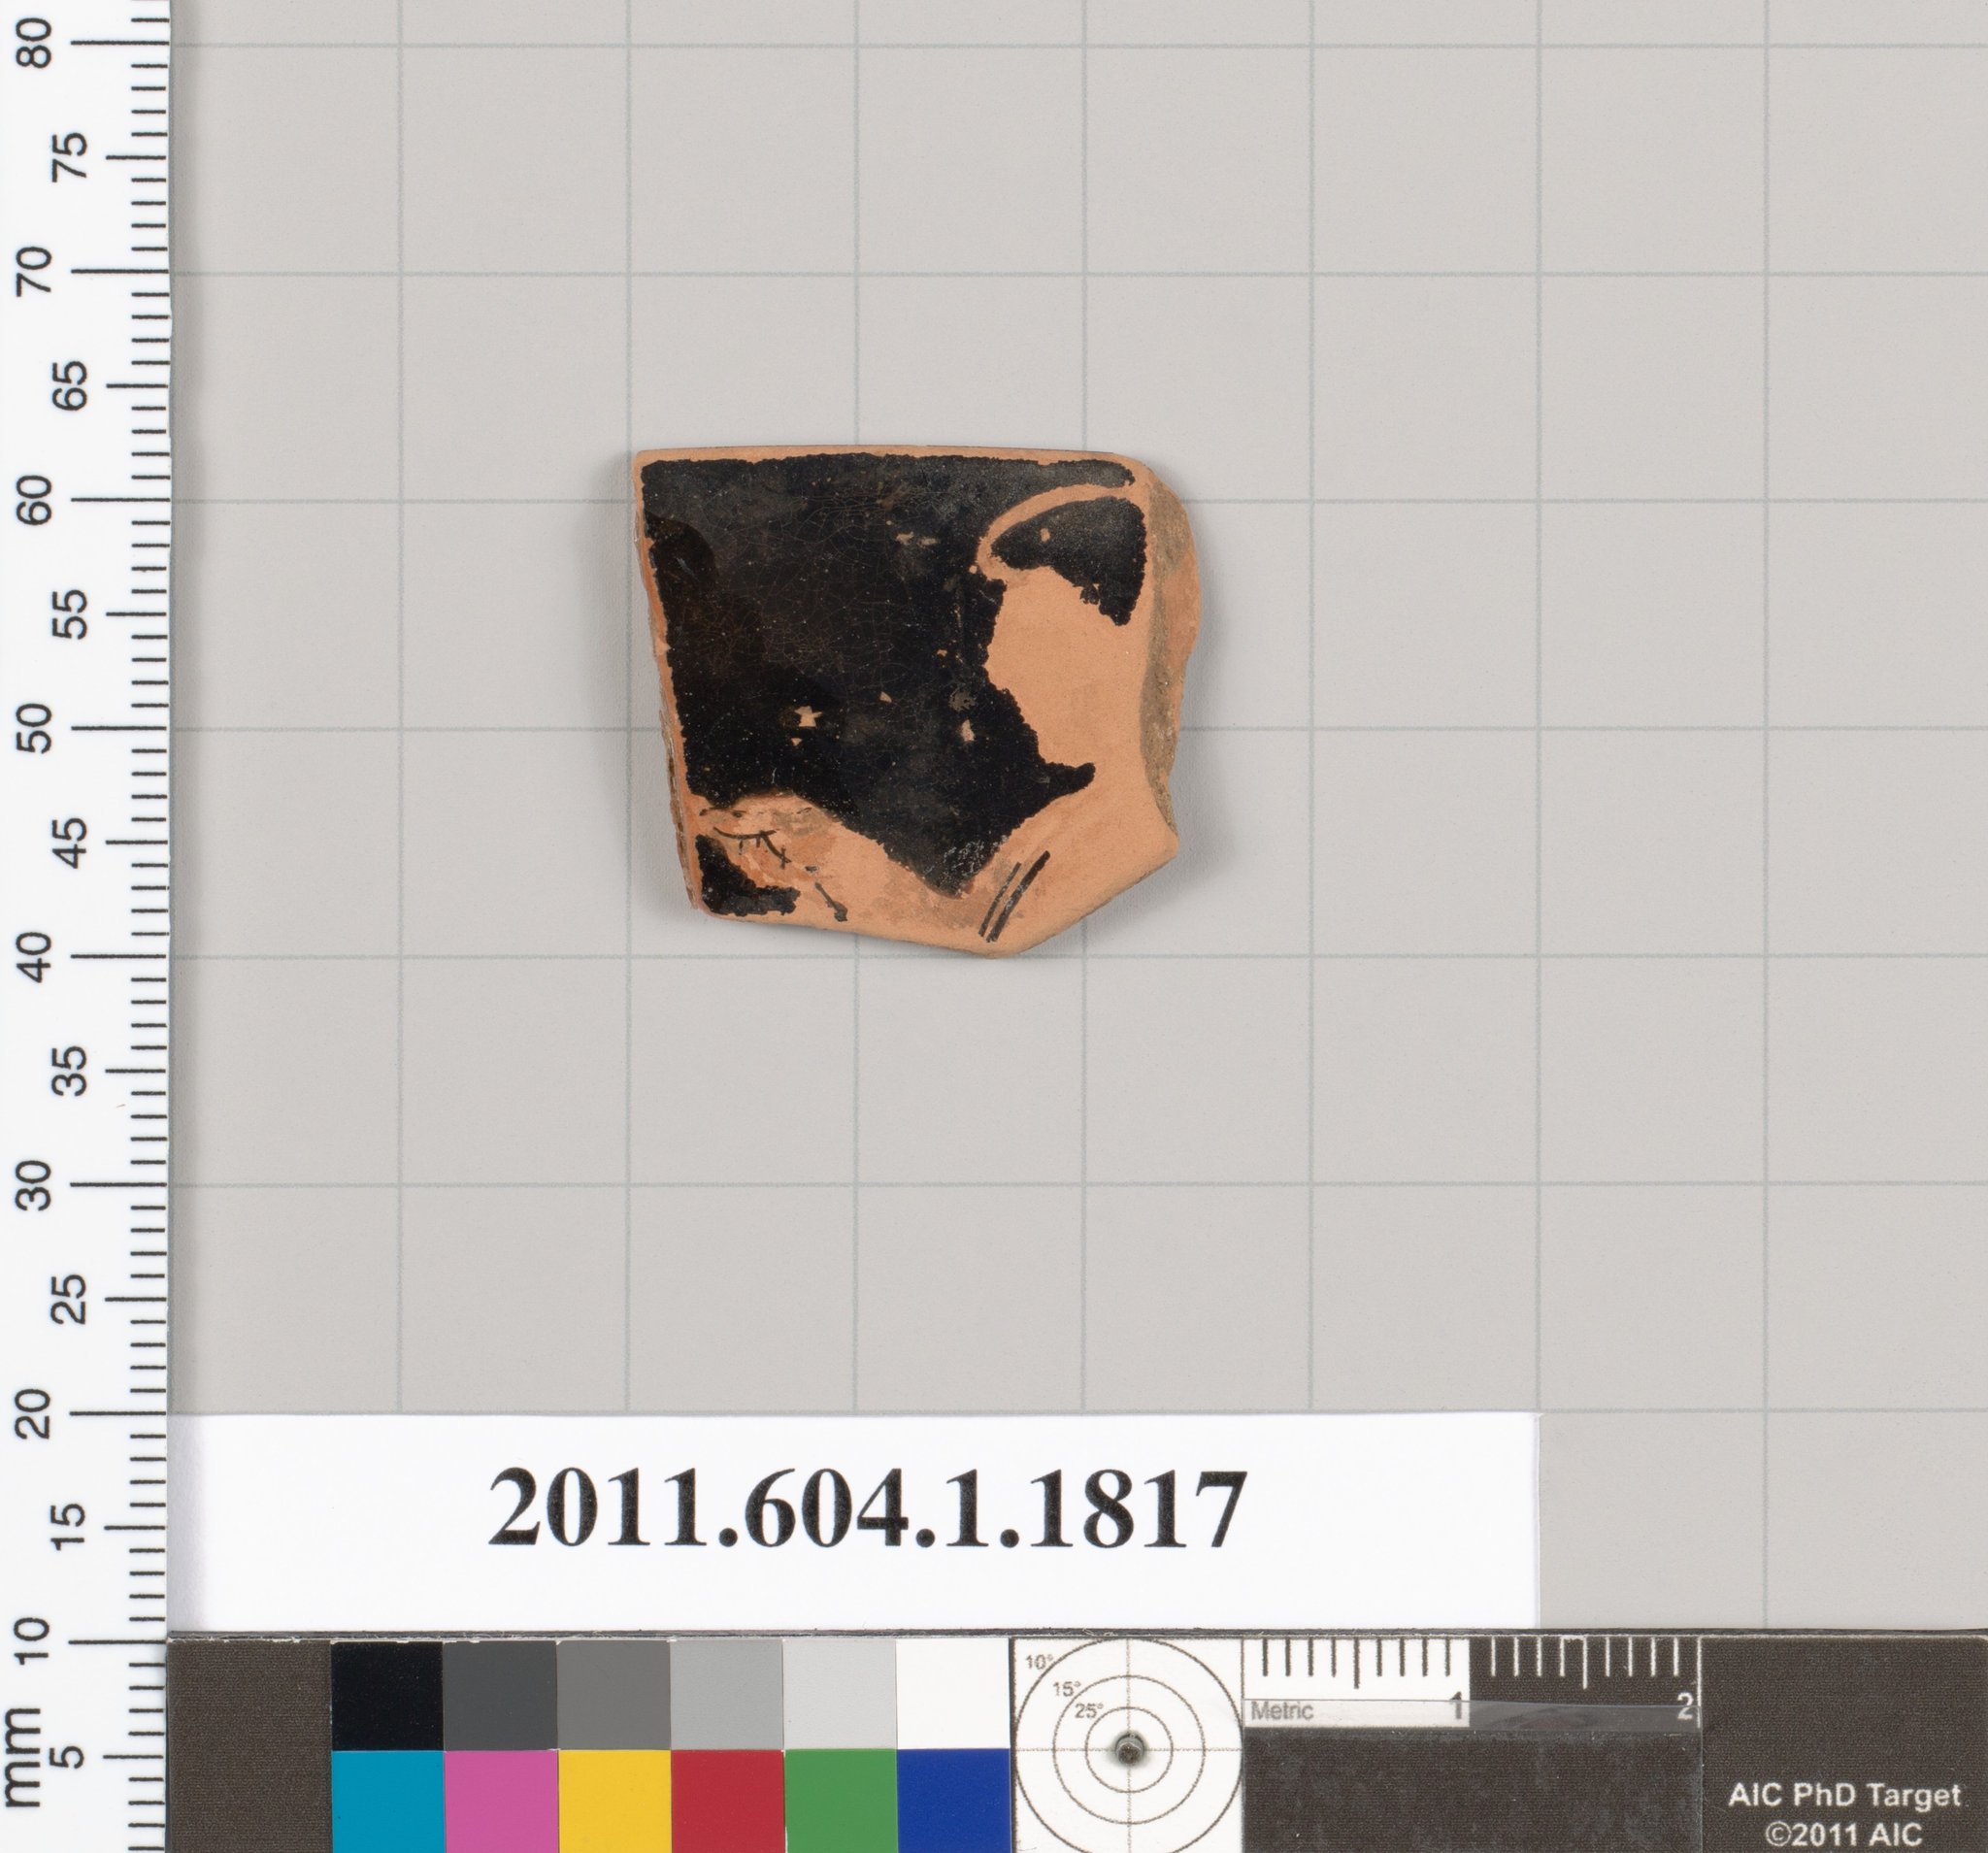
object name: kylix fragment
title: Terracotta rim fragment of a kylix (drinking cup)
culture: greek, attic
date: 475-451 BCE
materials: terracotta